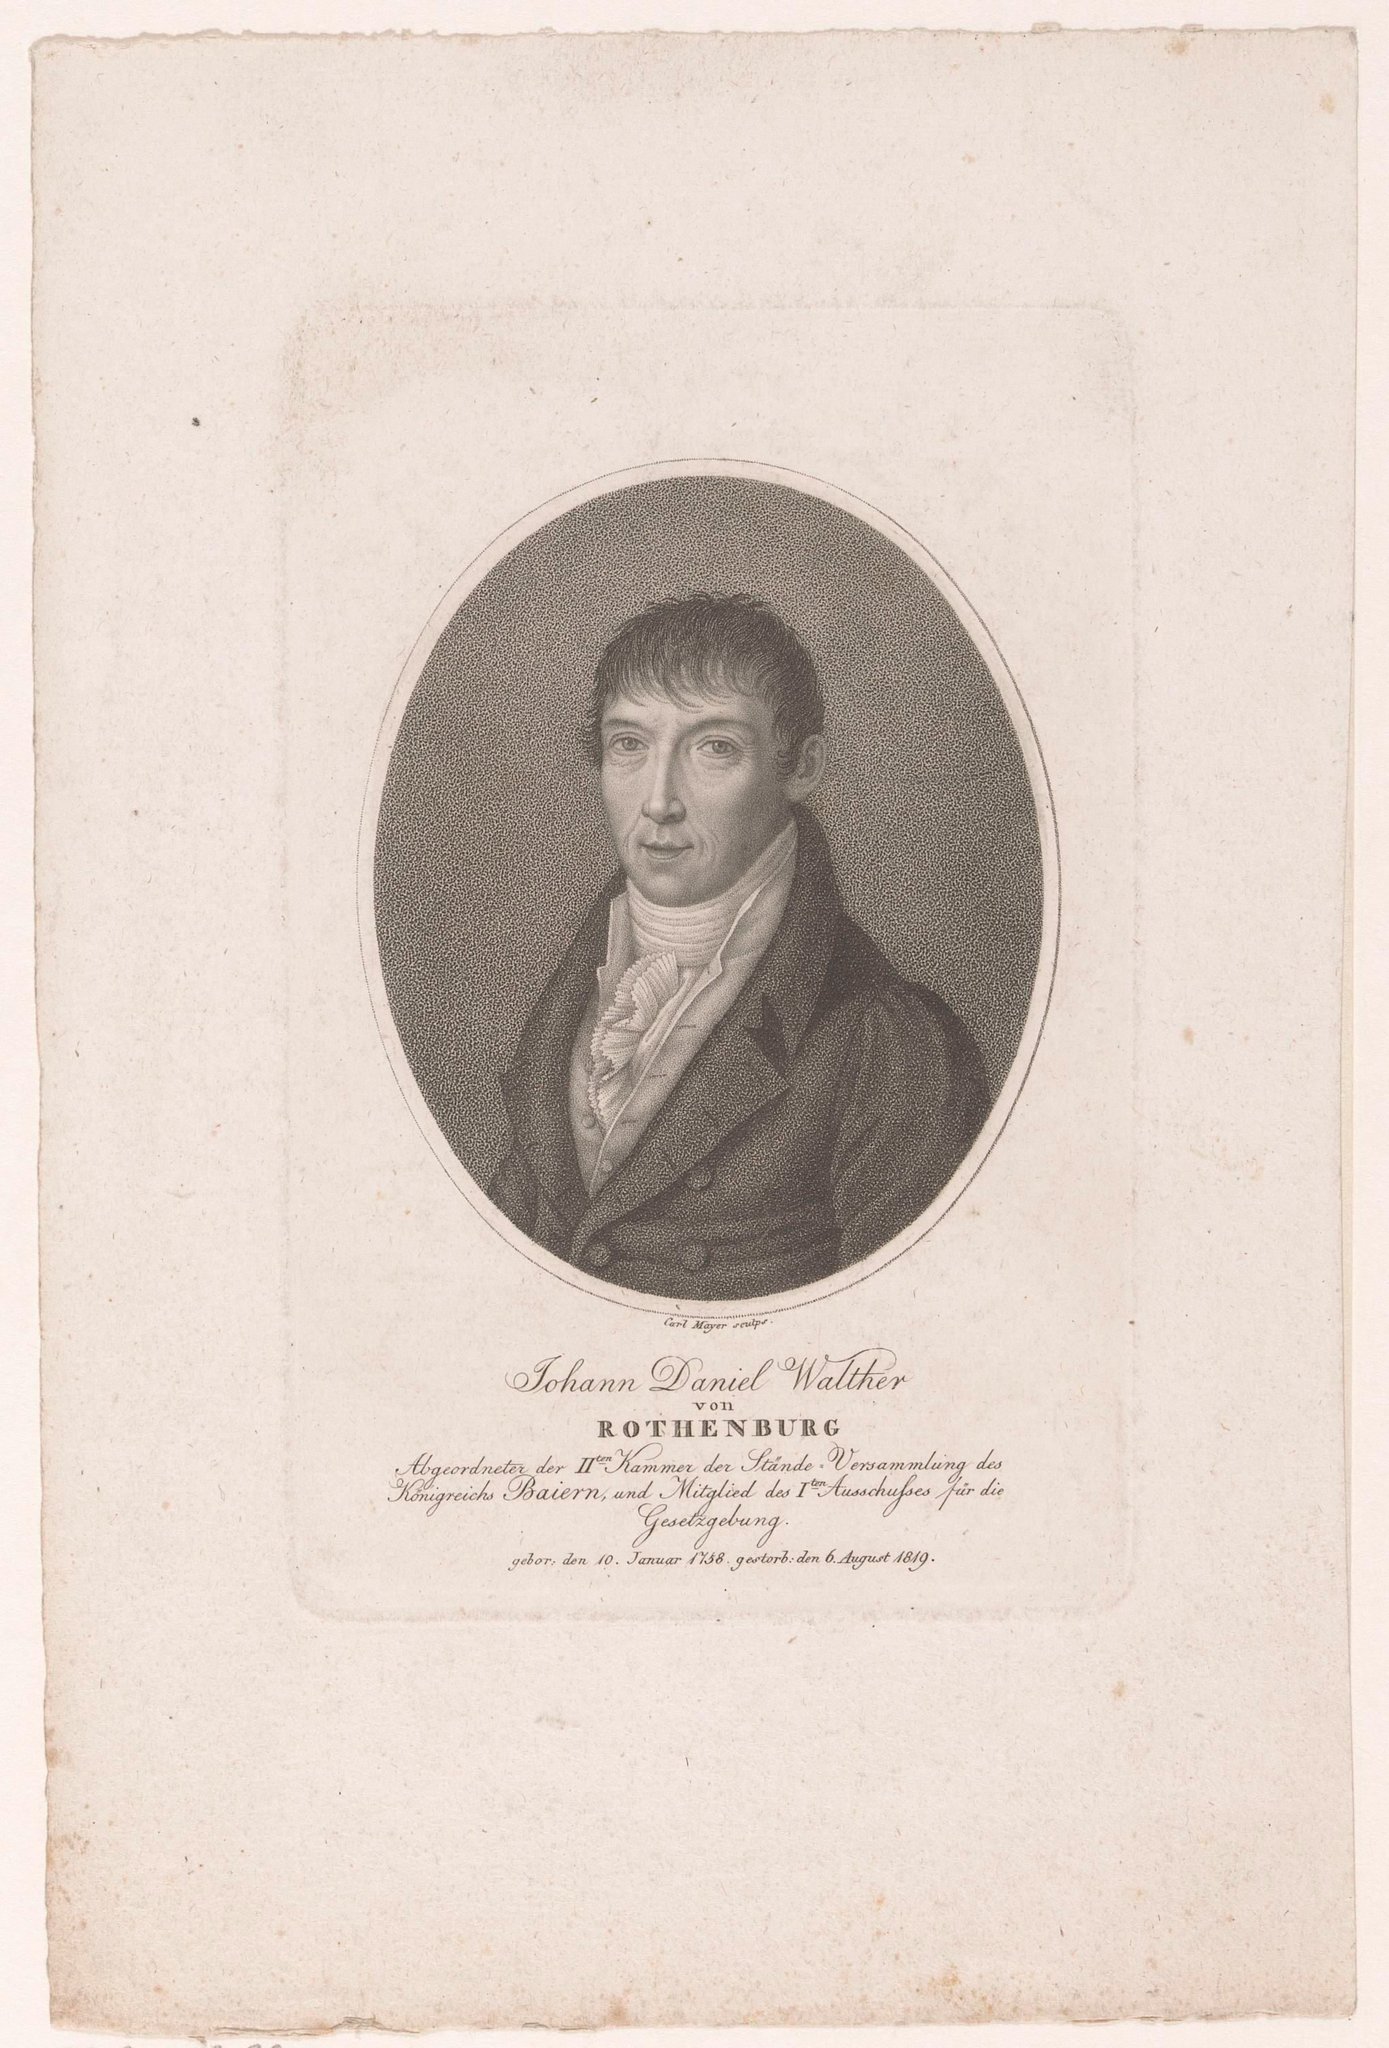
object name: print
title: Portret van Johann Daniel Walther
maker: carl mayer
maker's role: print maker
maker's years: 1798-1868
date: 1819-1868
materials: paper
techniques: engraving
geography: nuremberg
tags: historical persons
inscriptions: collector's mark: Lugt 2228